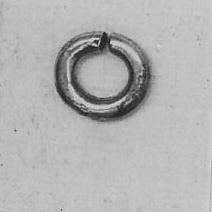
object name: earring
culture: japanese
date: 601-700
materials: silver